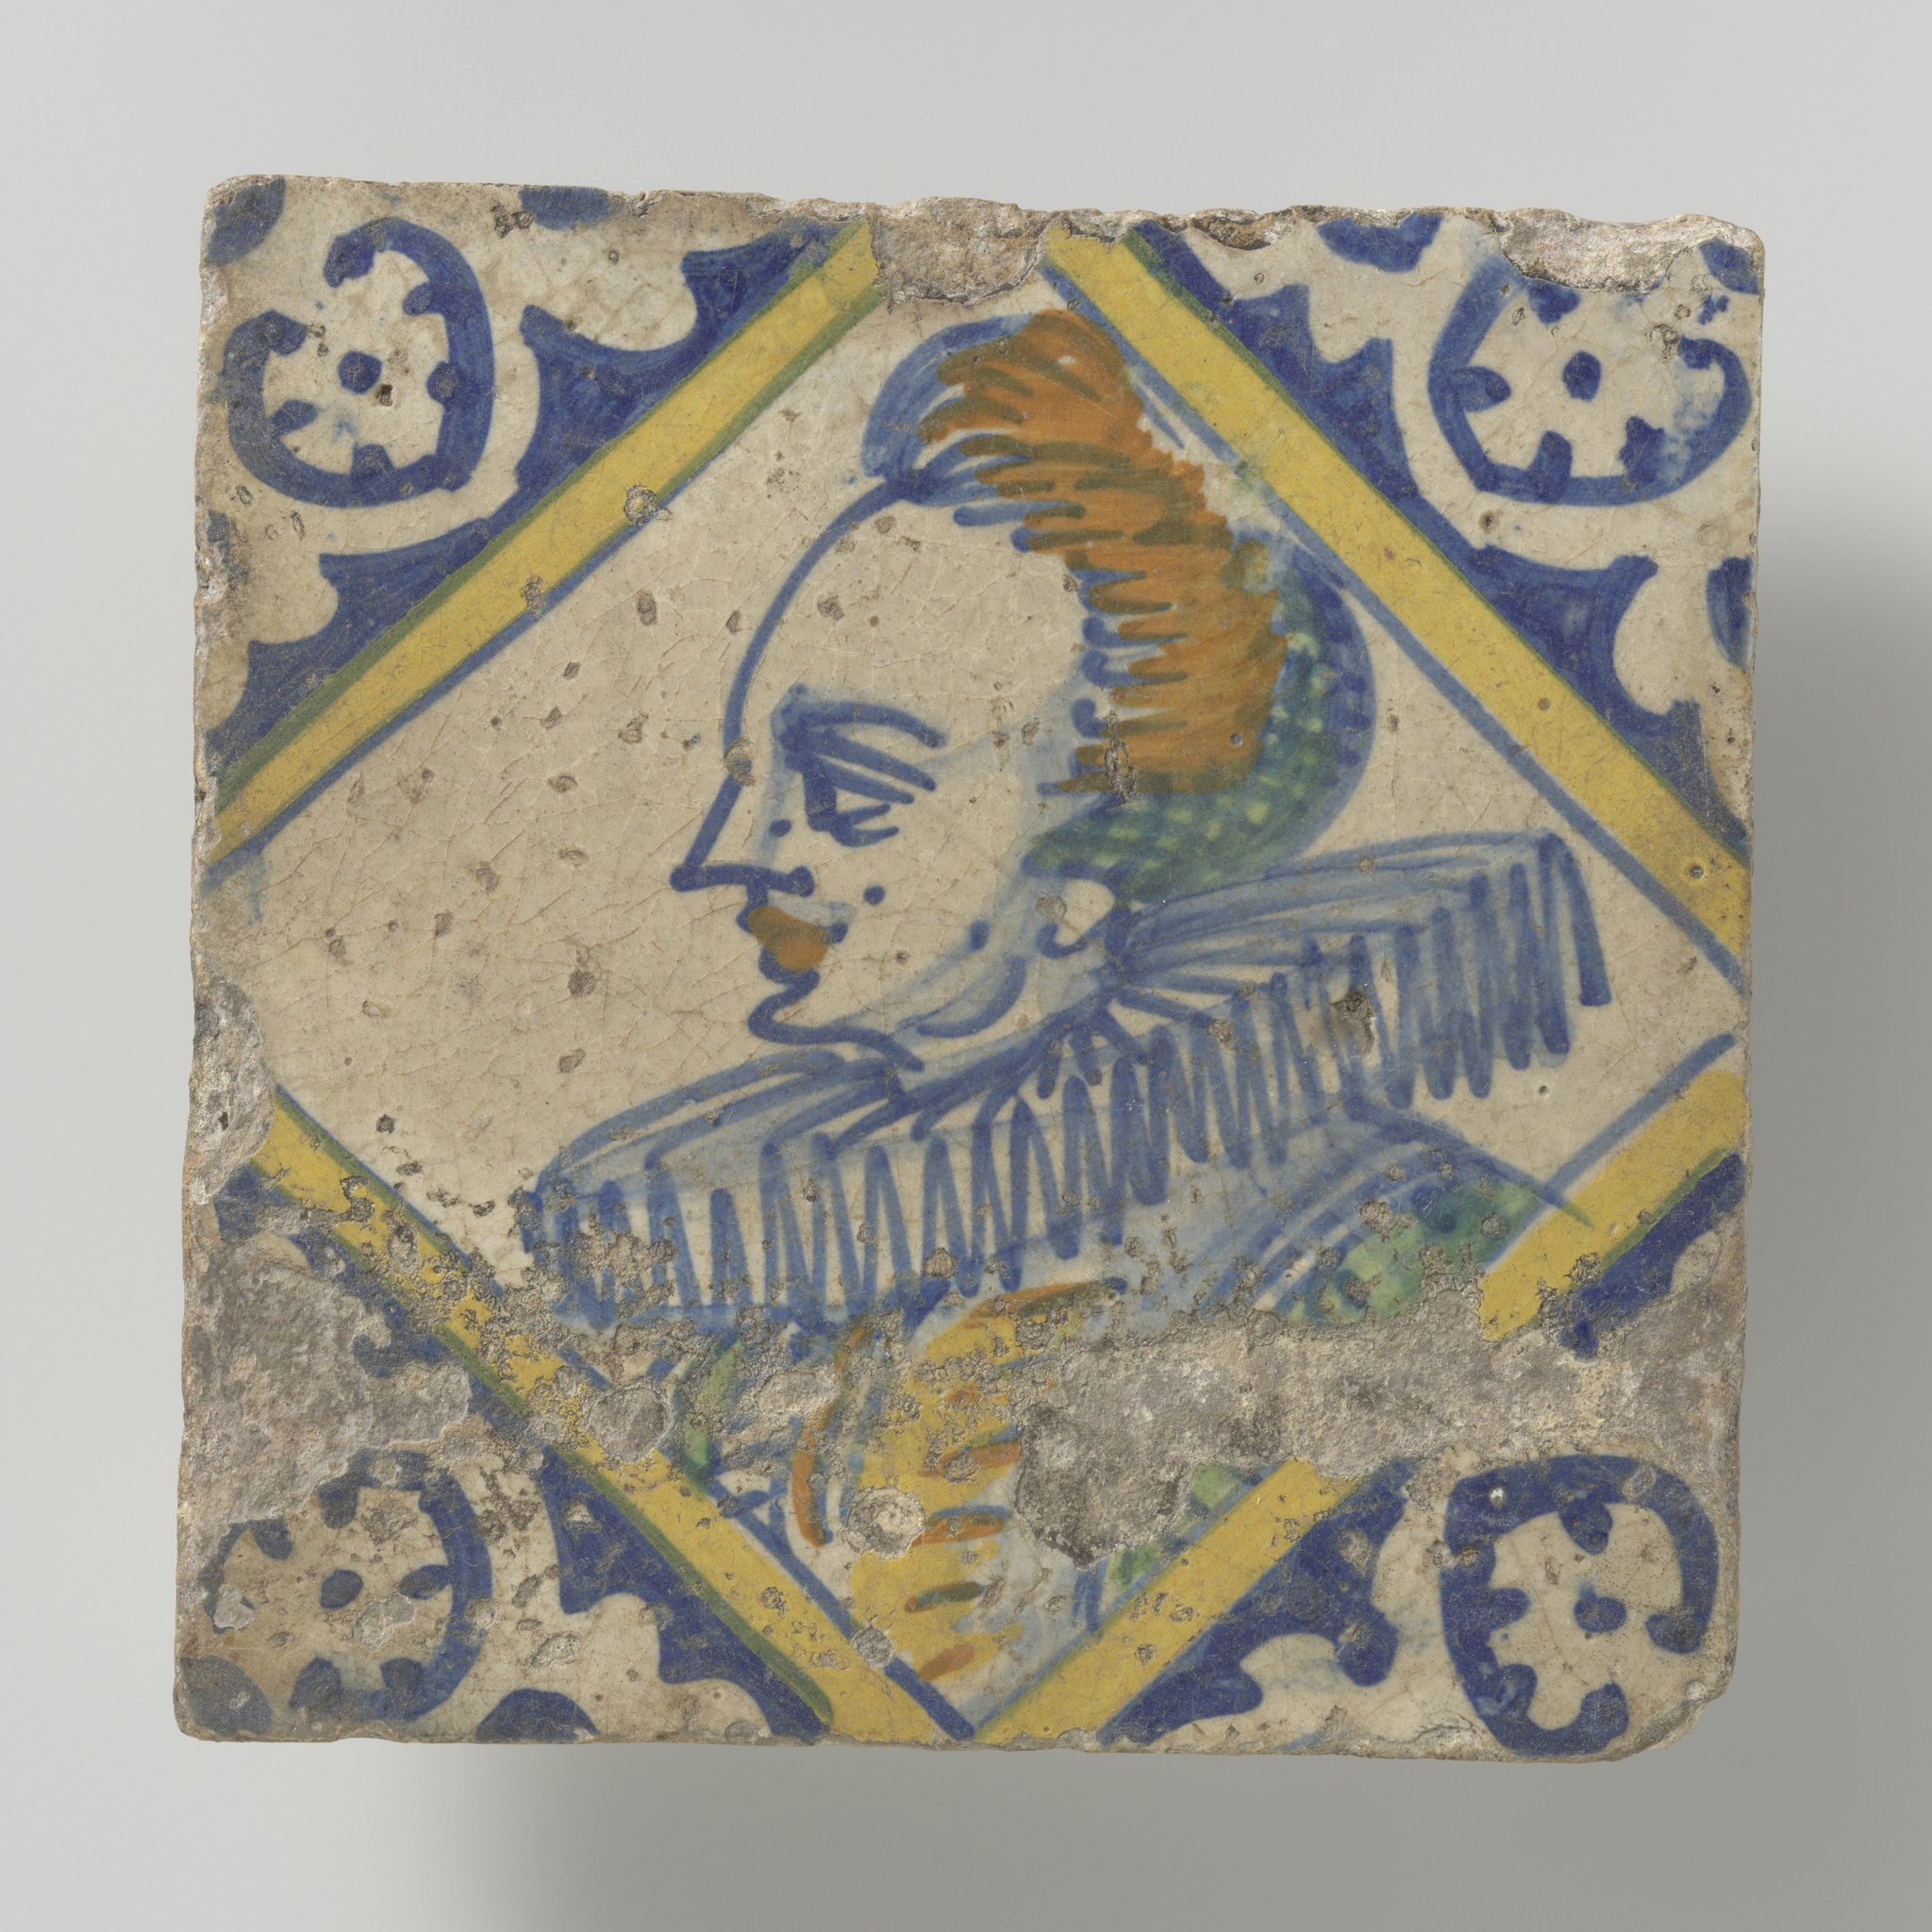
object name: tile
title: Tegel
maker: Anonymous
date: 1620-1640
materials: earthenware, glaze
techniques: maiolica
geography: netherlands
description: Tegel met een veelkleurig portret van een vrouw binnen een kwadraat omlijsting en in de hoeken vultechniek ornament.